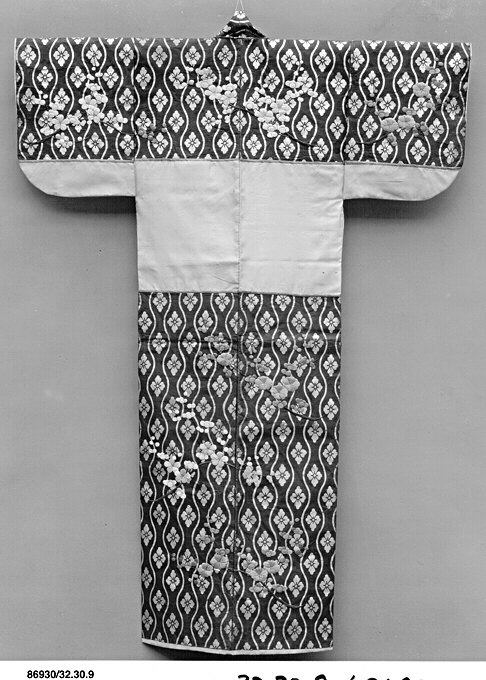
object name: noh costume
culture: japanese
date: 1690-1799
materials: silk